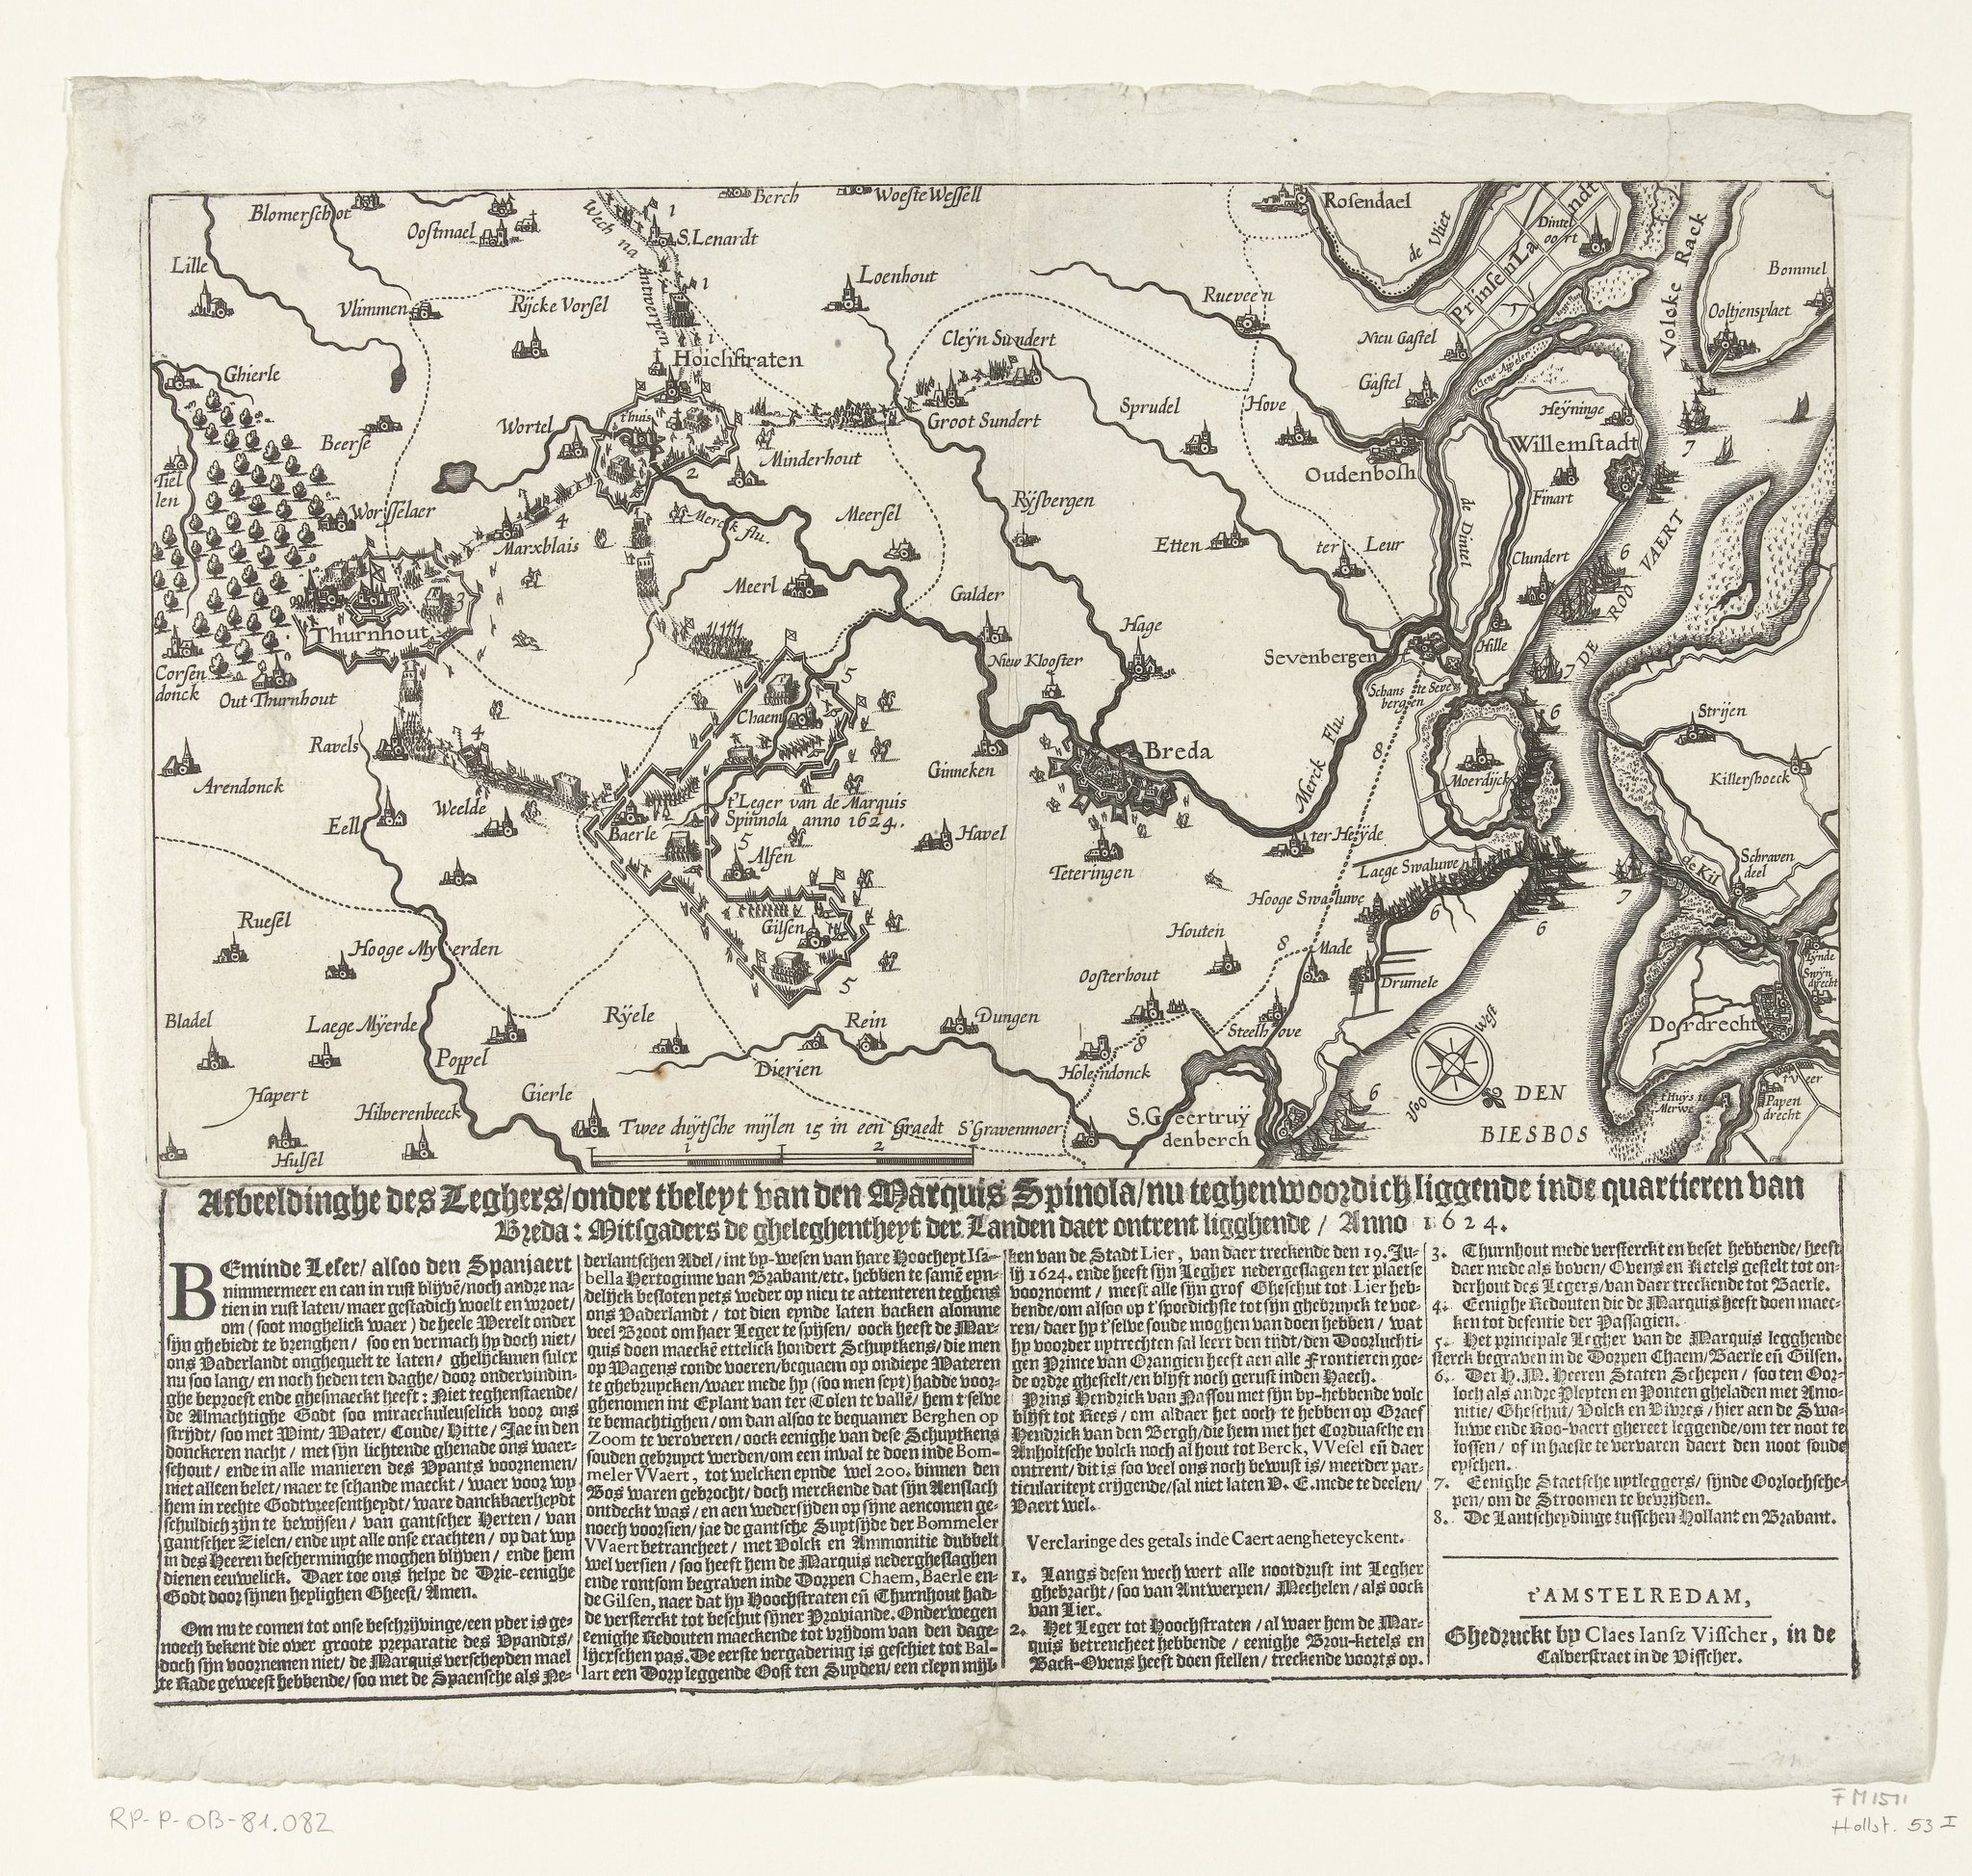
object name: print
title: Afbeeldinghe des Leghers / onder tbeleyt van den Marquis Spinola / nu teghenwoordich liggende inde quartieren van Breda: Mitsgaders de Gheleghentheyt der Landen daer ontrent ligghende / Anno 1624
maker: claes jansz. visscher (ii)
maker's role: draughtsman, print maker, publisher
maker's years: 1586-1652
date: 1624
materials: paper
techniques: etching, letterpress printing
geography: amsterdam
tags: maps of separate countries or regions, siege, position war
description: Begin van het beleg van Breda door het Spaanse leger onder Spinola, 19 juli 1624. Kaart van Breda en het omringende land van Dordrecht tot Turnhout. Op het blad onder de plaat 4 kolommen tekst met de legenda 1-8 in het Nederlands.